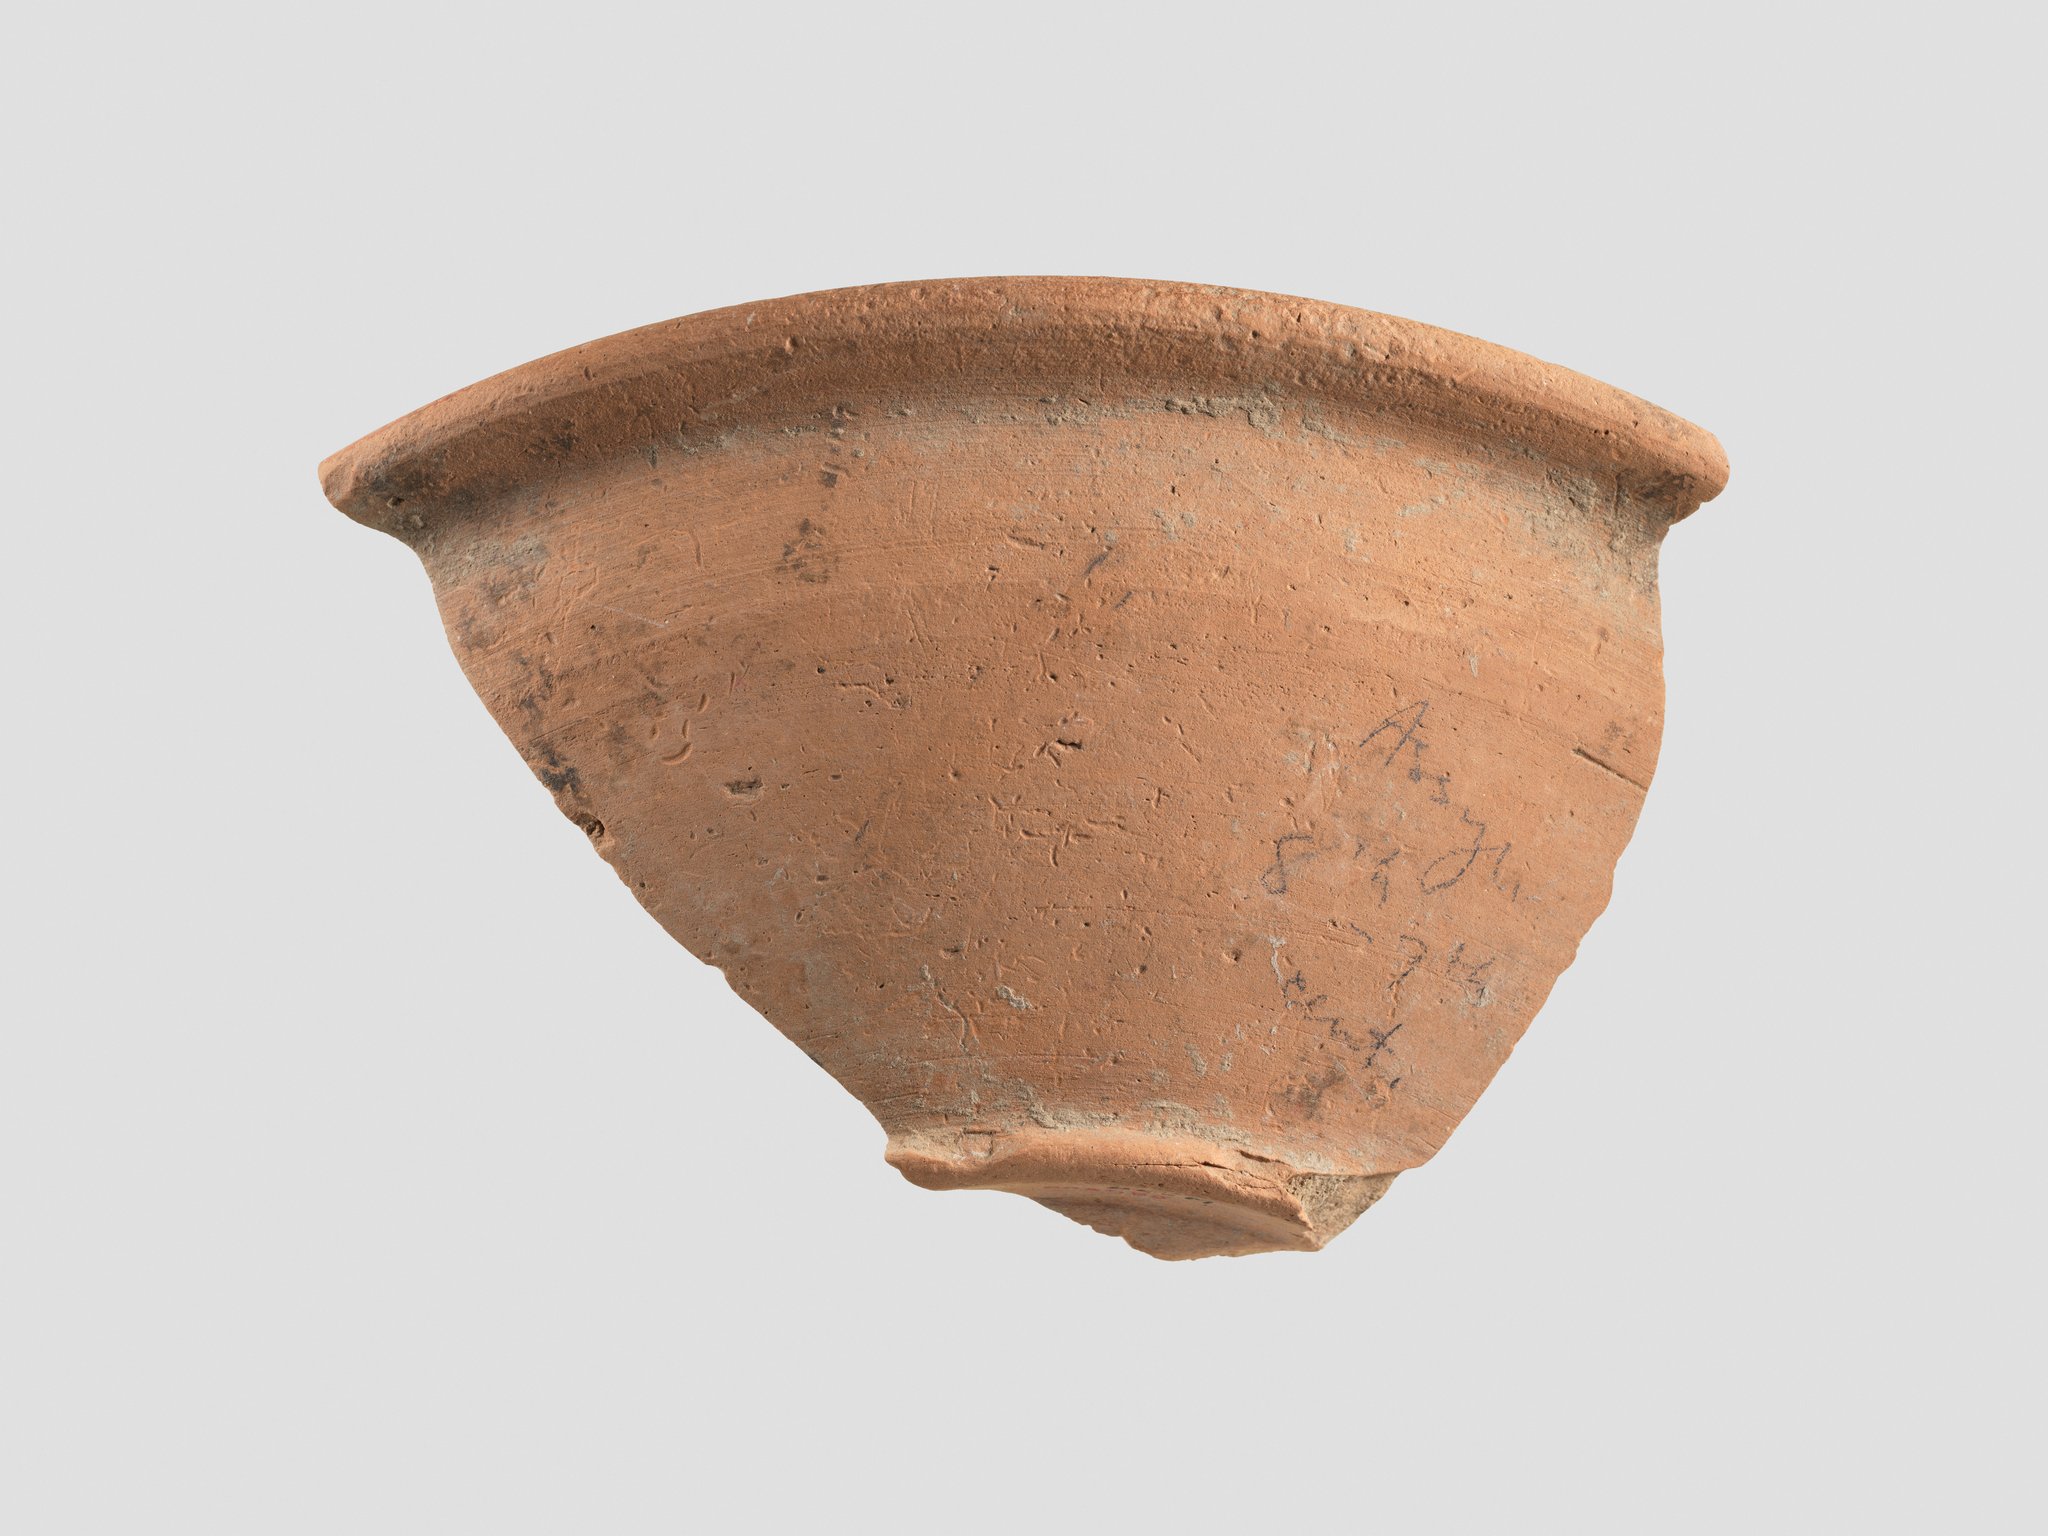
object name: bowl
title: Bowl sherd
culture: assyrian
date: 800-601 BCE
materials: ceramic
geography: mesopotamia